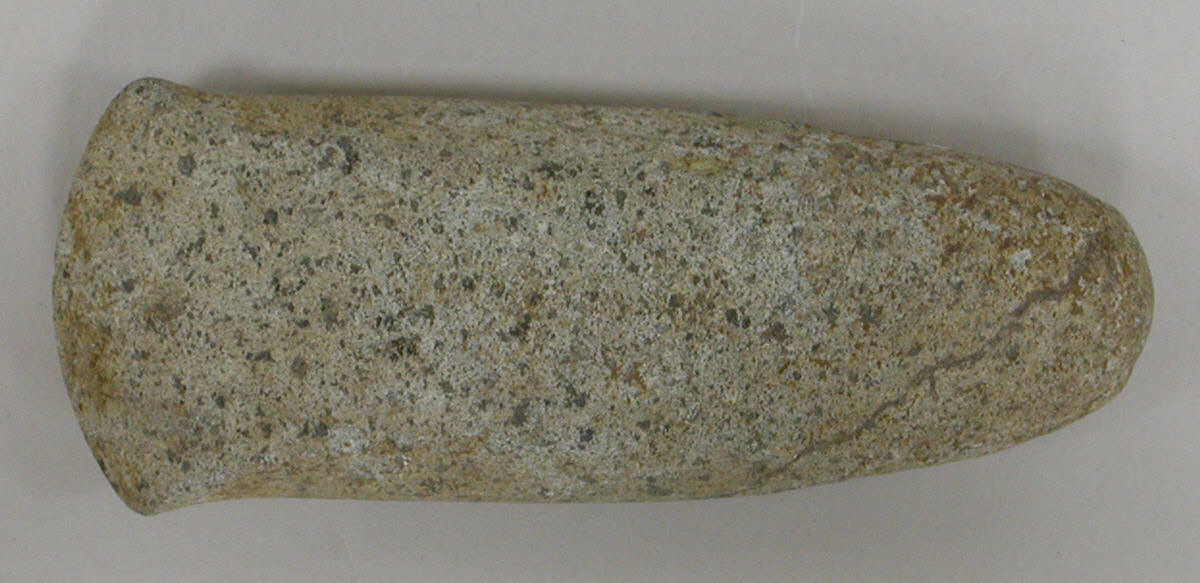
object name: celt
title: Stone Celt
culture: costa rican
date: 1501-1600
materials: stone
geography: costa rica